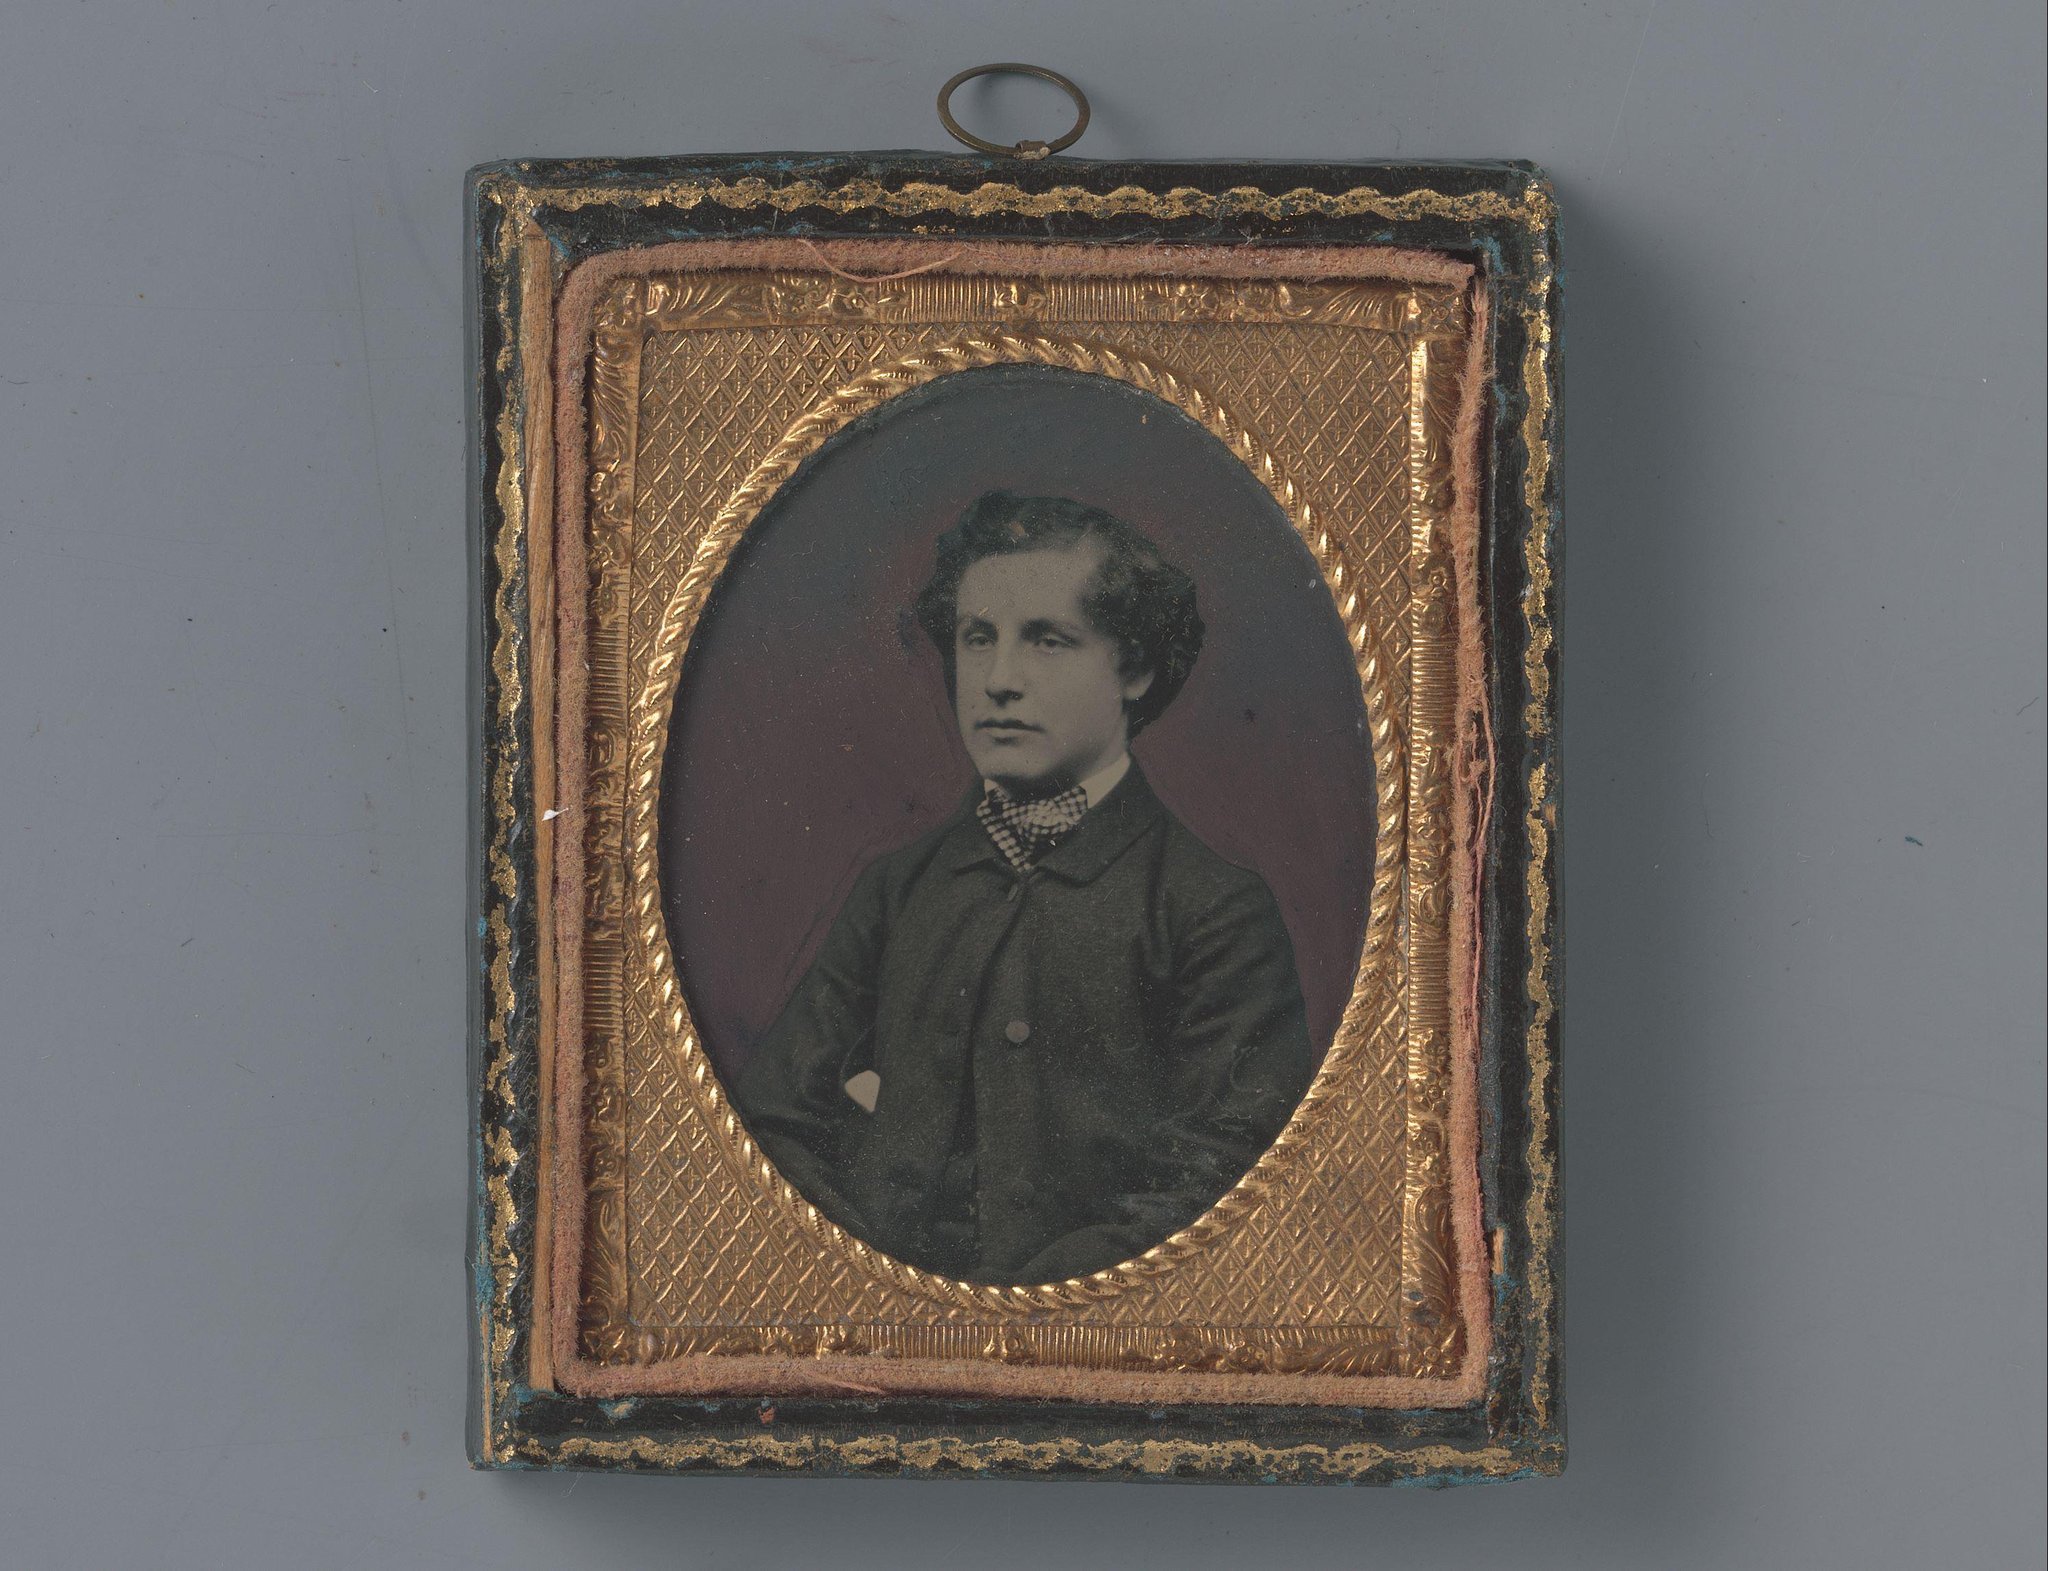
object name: photograph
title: Portret van een onbekende jongeman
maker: Anonymous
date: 1855-1870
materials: glass, metal, paper, velvet, wood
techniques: ambrotype, hand coloring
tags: historical persons, youth, adolescent